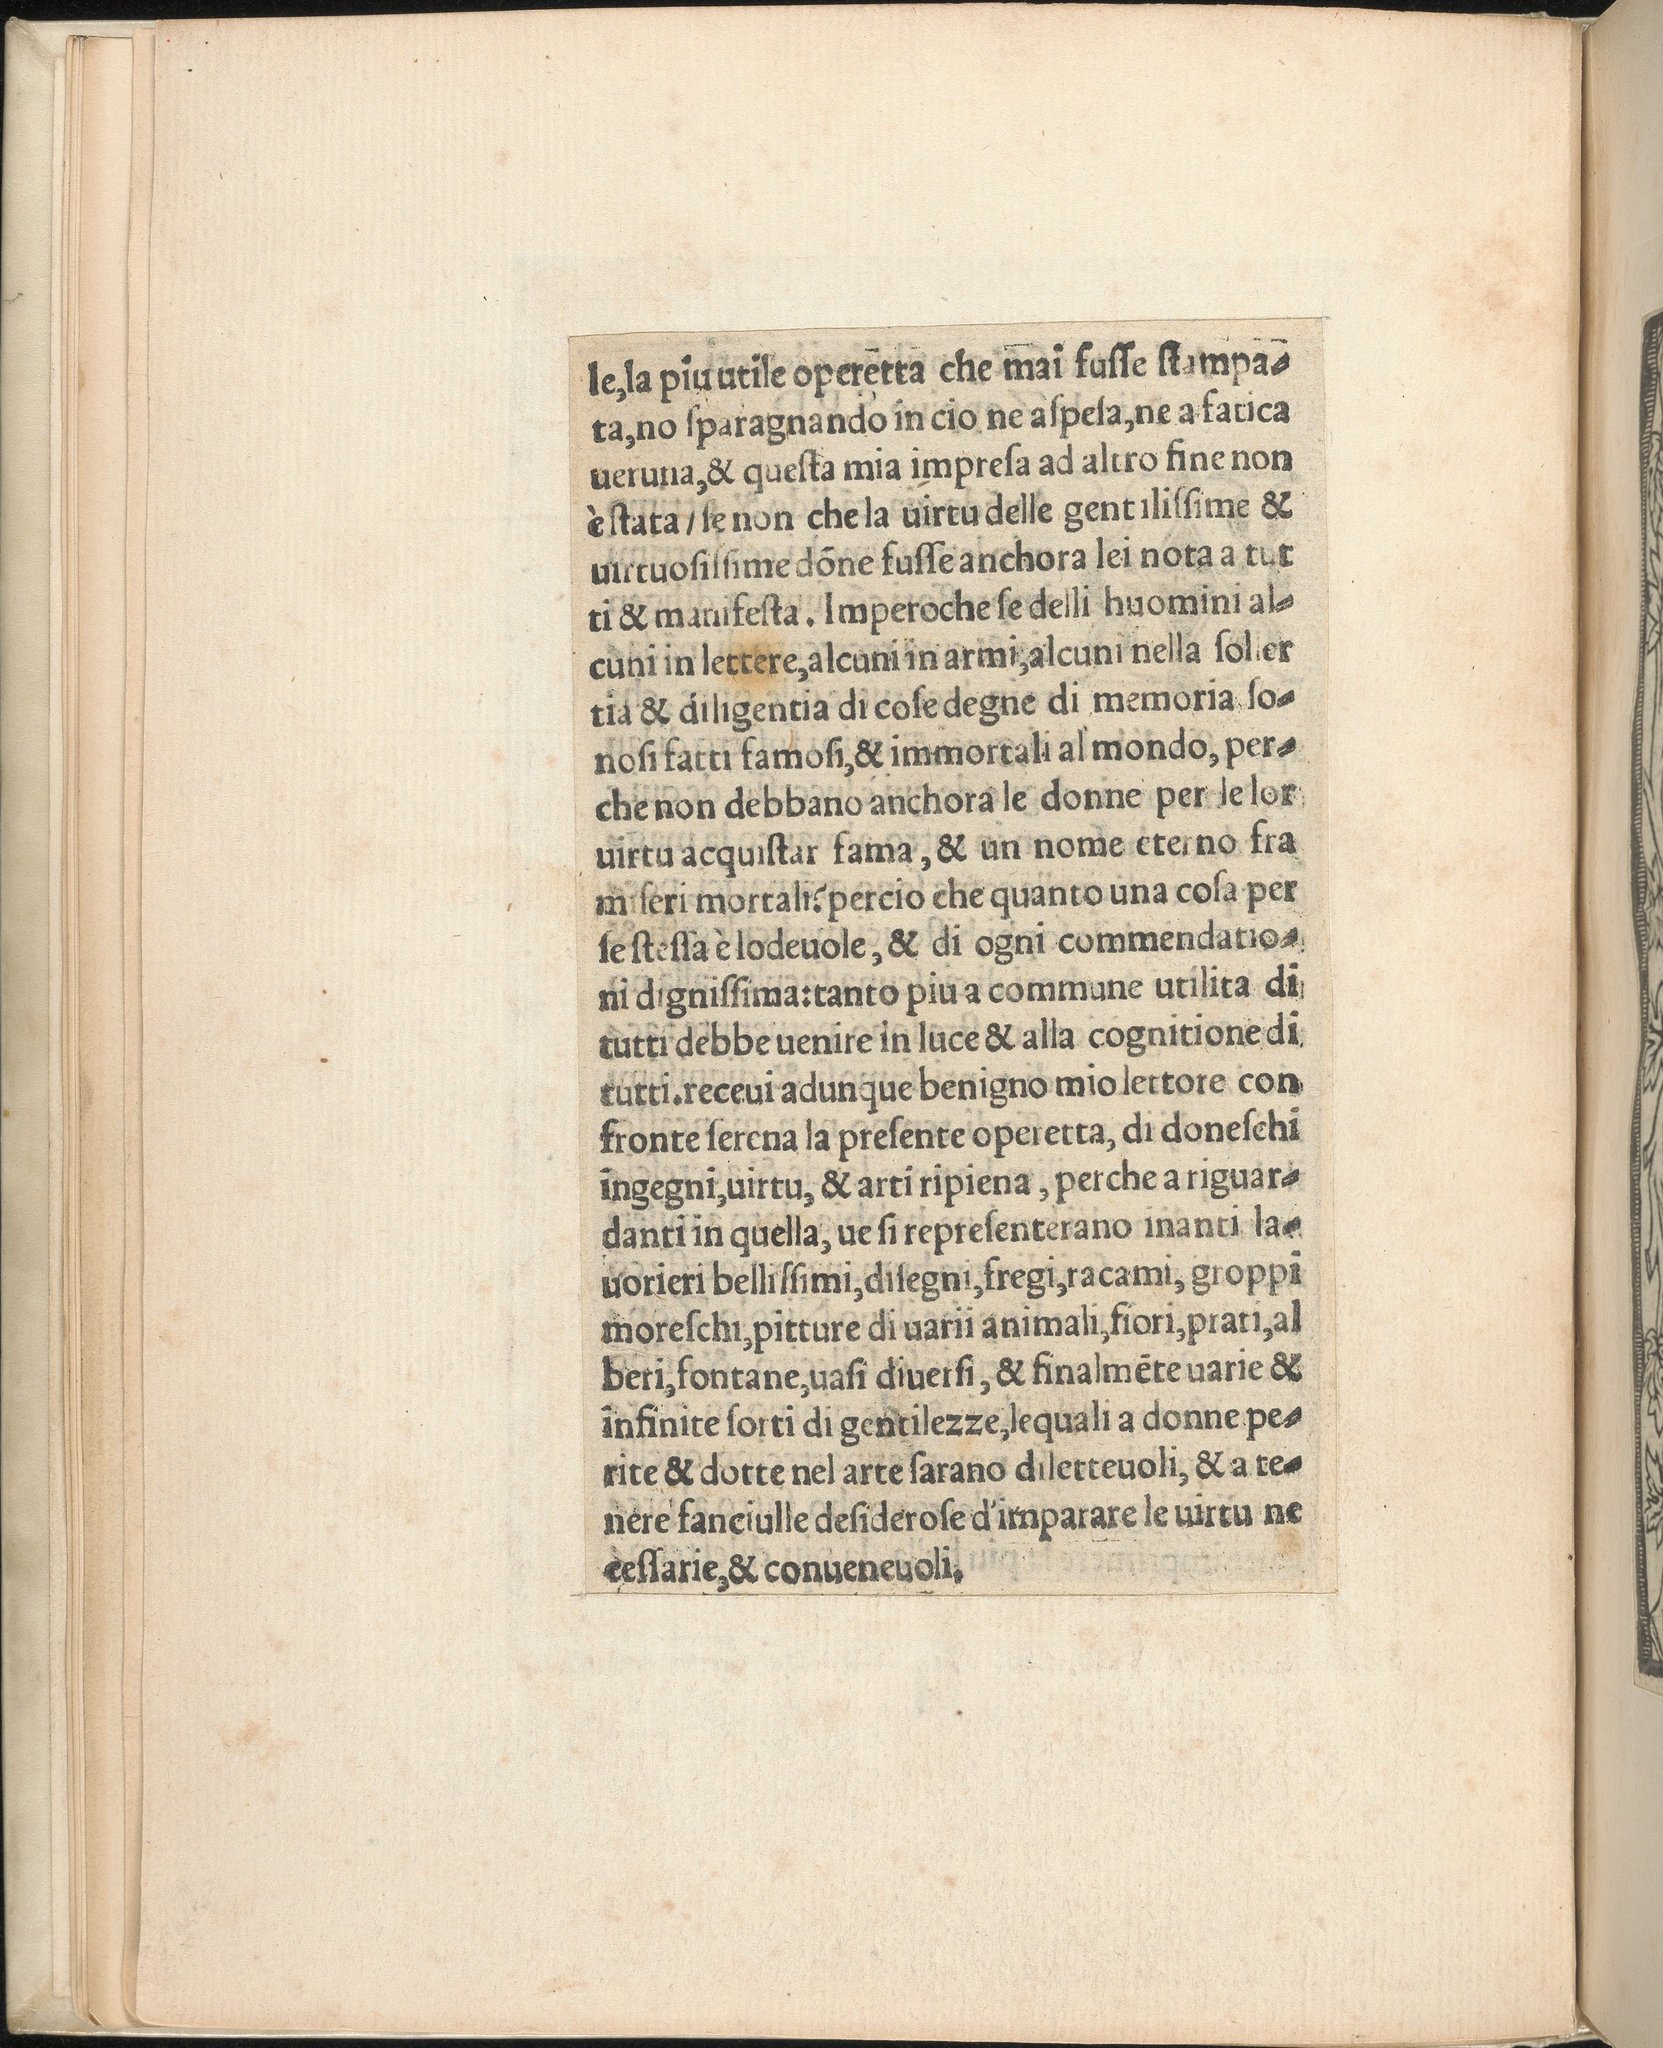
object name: book print ornament architecture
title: Esemplario di lavori, page 2 (verso)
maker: nicolò zoppino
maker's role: publisher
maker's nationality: italian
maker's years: 1478-1544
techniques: bookbinding, inlay, woodcut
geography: italy